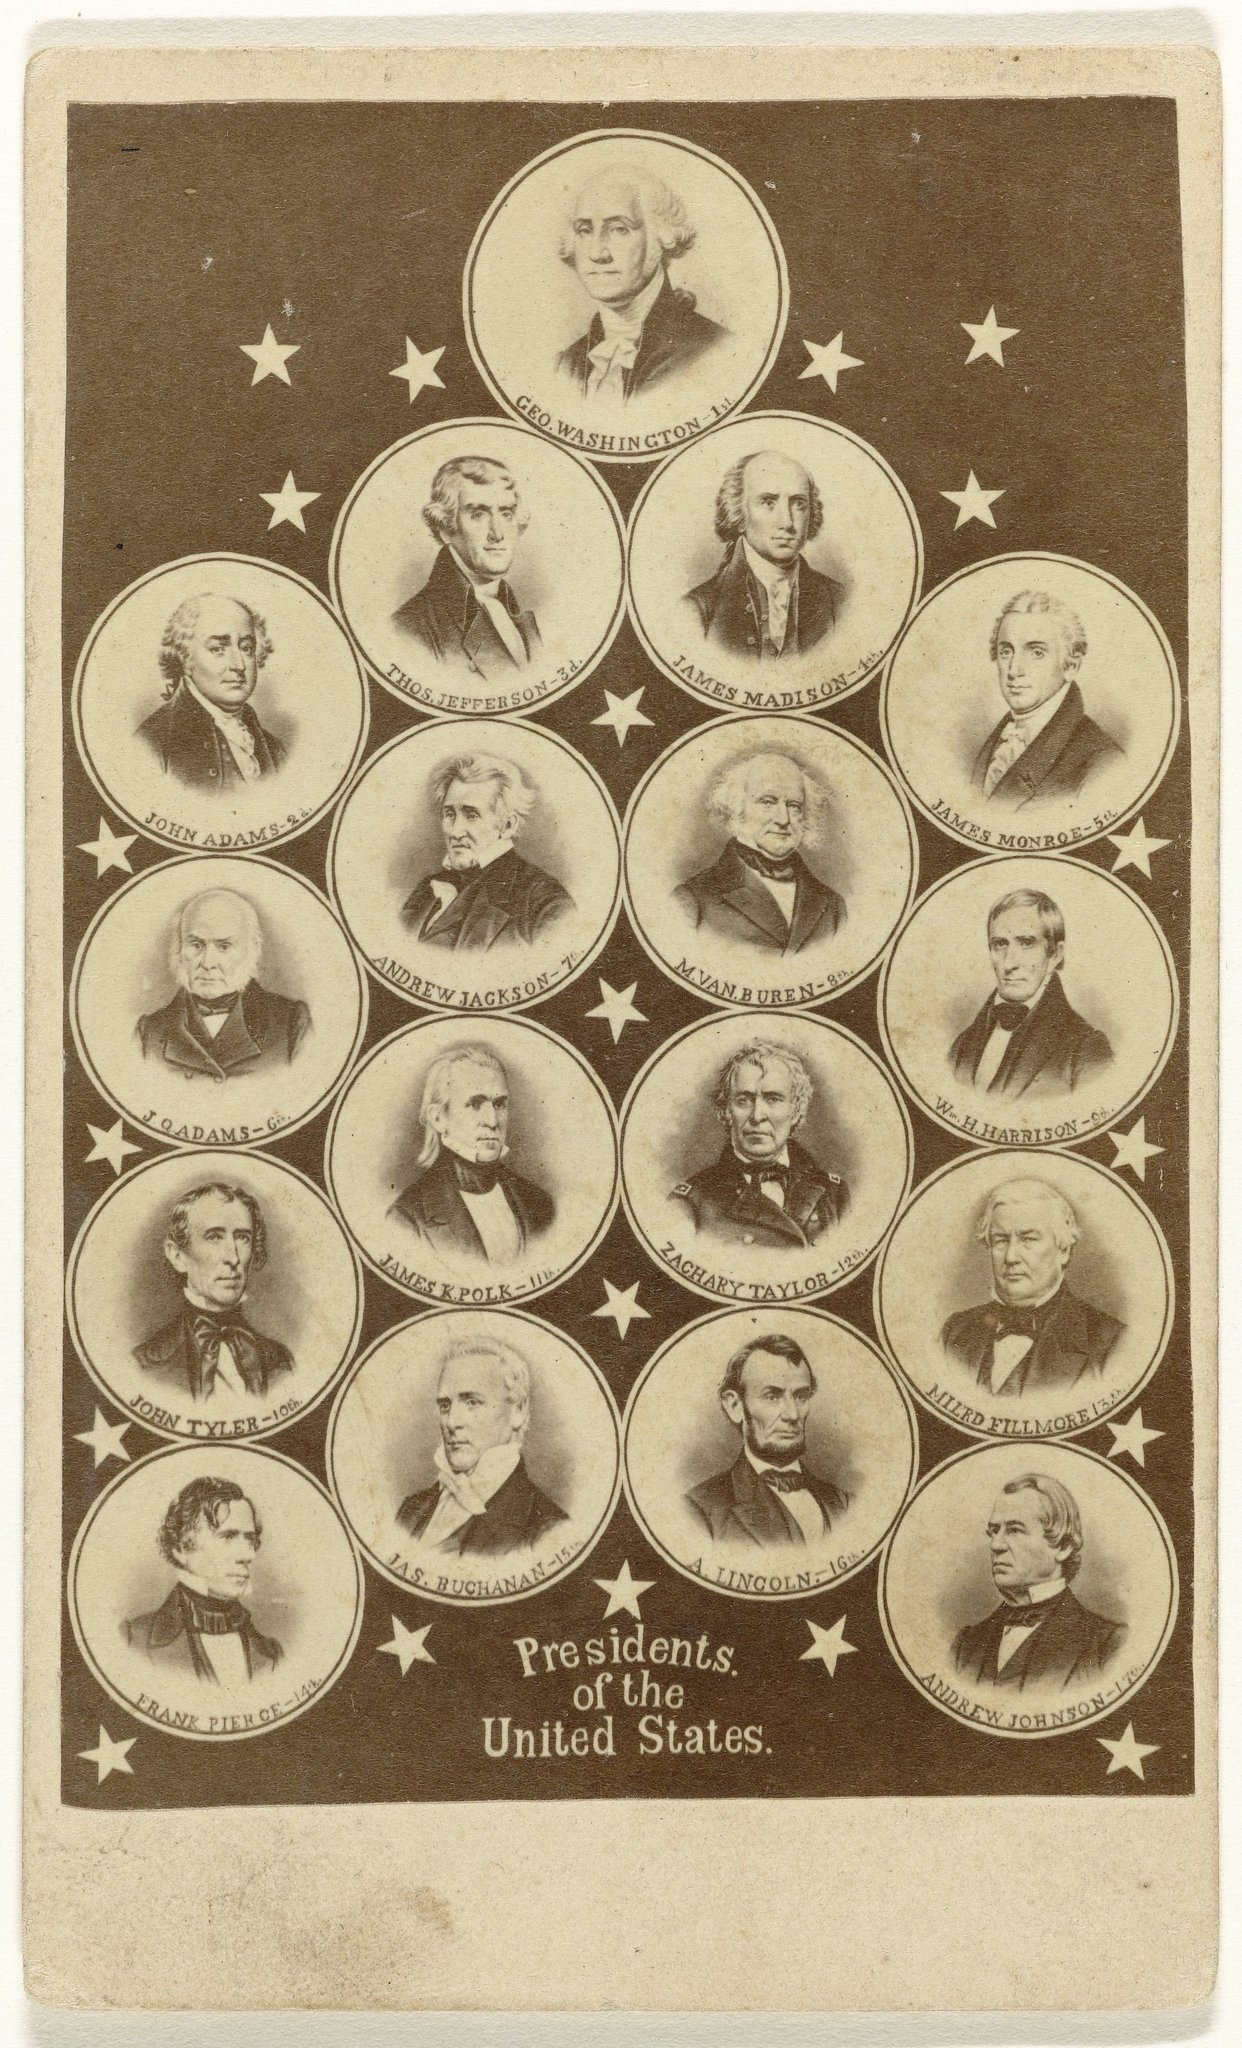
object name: carte de visite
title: Compositie van portretten van 17 Amerikaanse presidenten, van George Washington tot en met Andrew Johnson (1789-1869)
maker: Anonymous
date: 1865-1869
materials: cardboard, paper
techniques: albumen print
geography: north and central america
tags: new york (city), president ~ head of republic, historical persons, united states of america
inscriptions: annotation: ‘Presidents. / of the / United States’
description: Compositie van 17 portretten van Amerikaanse presidenten in rondjes en sterren met onderschrift.